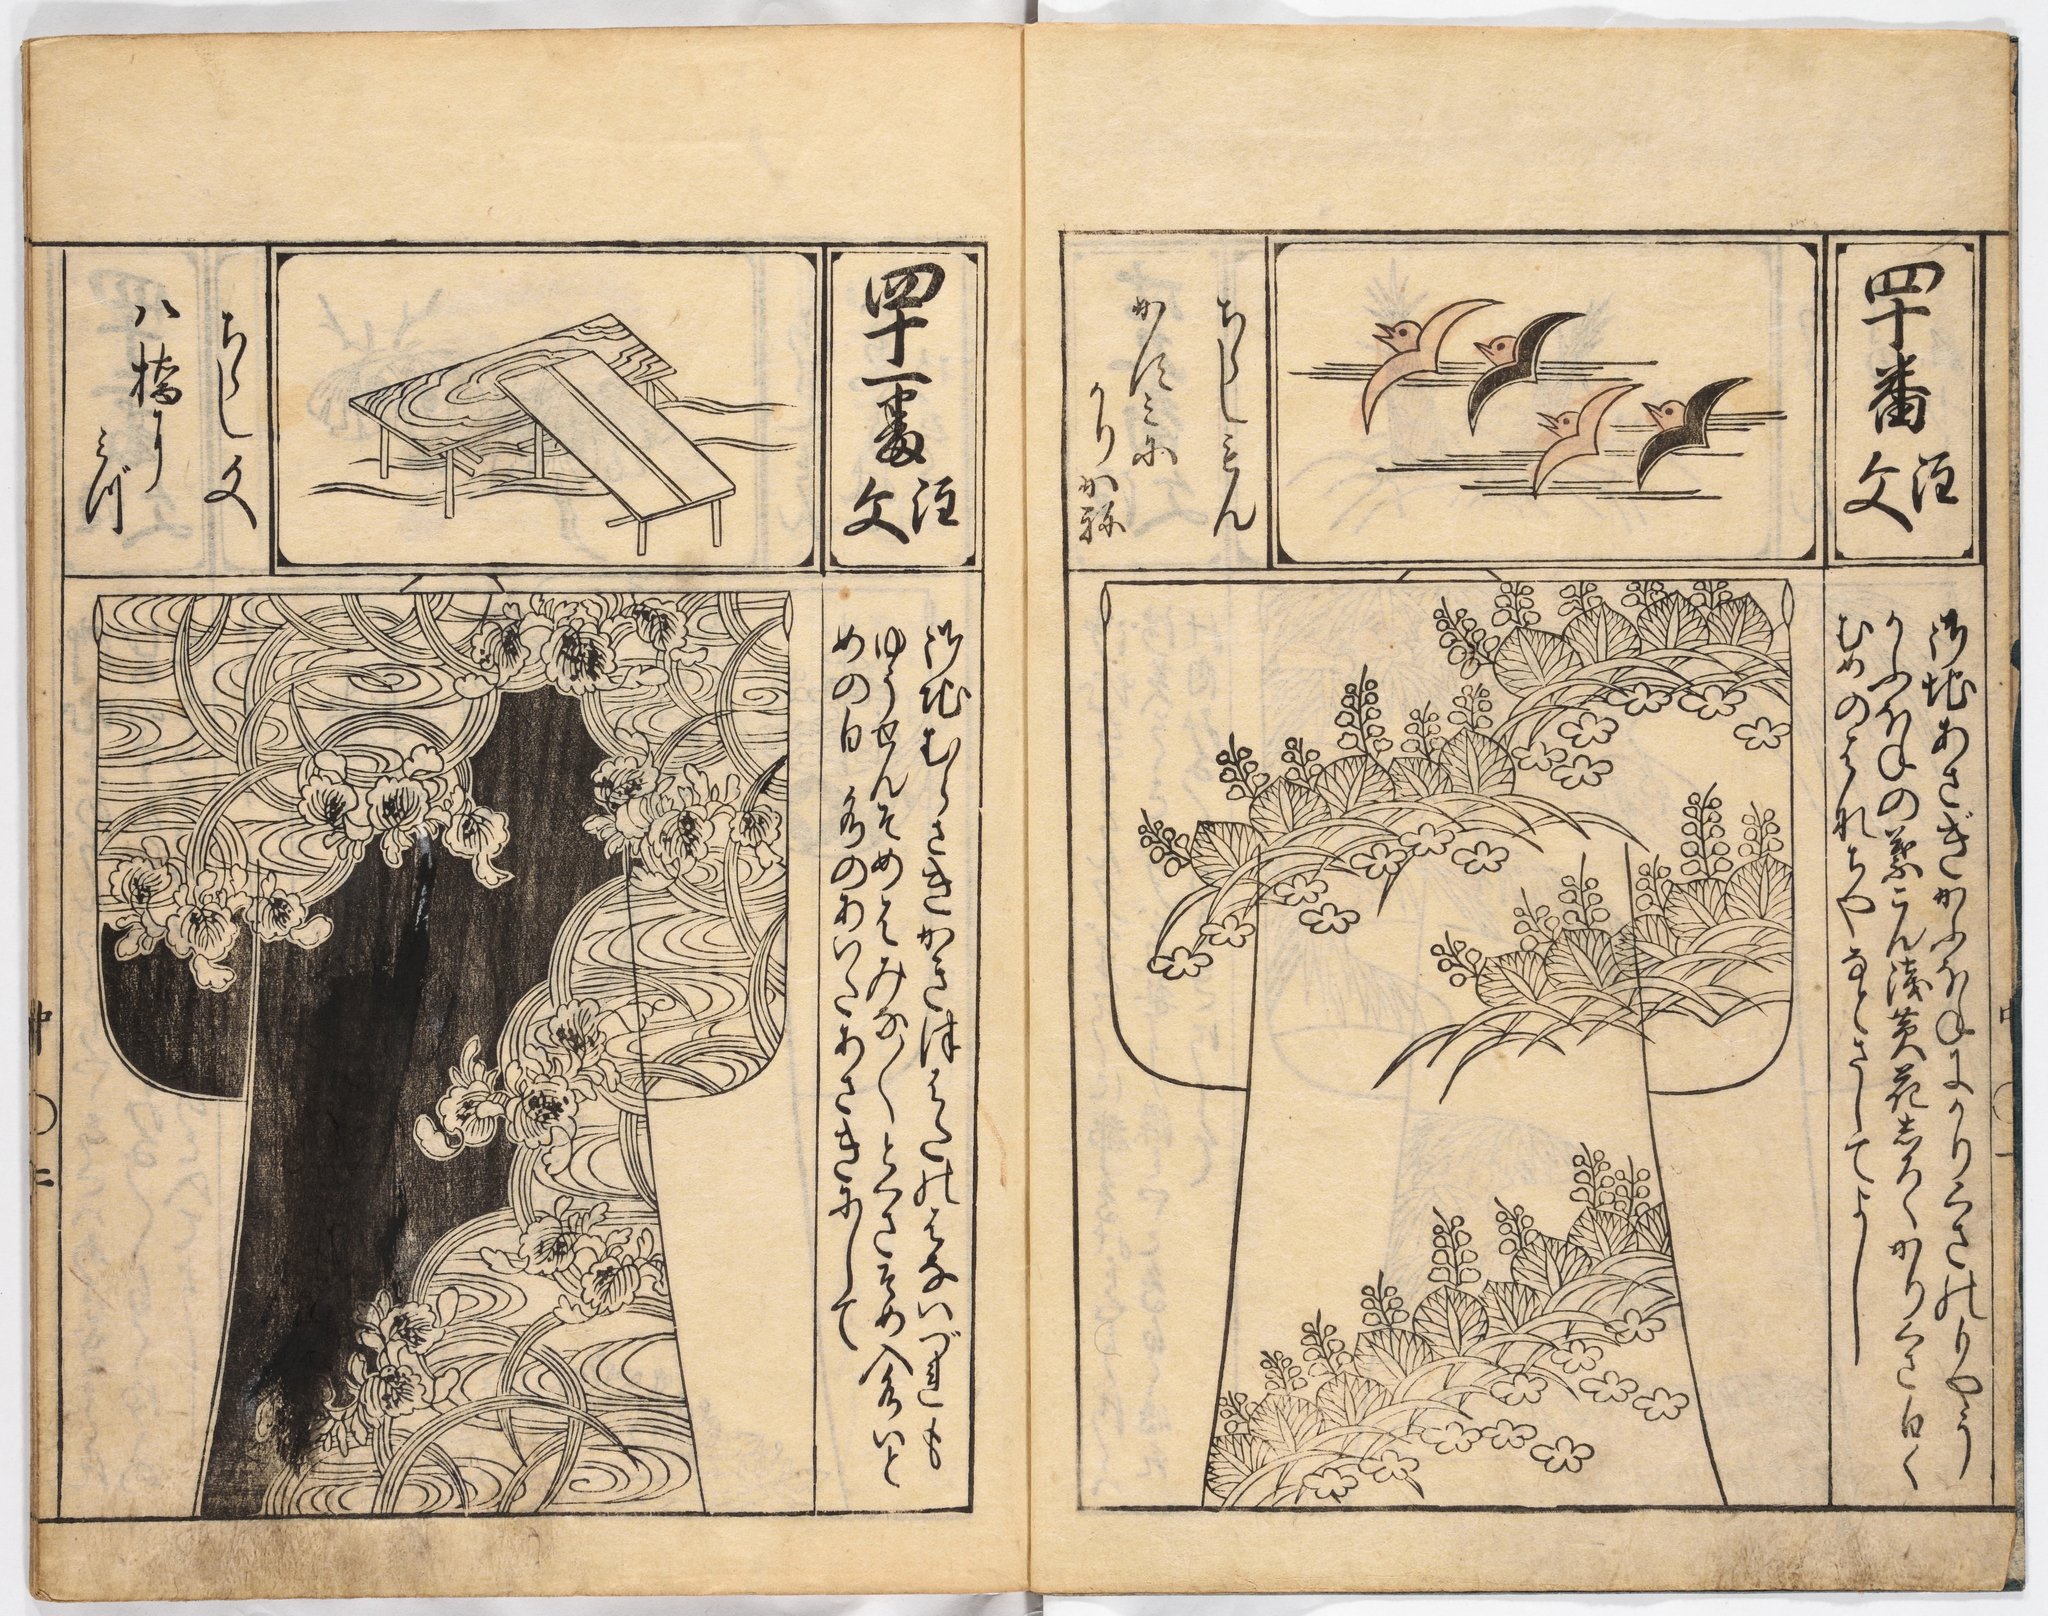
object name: illustrated book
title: (Untitled) Volume 2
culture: japanese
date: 1716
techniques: woodblock print